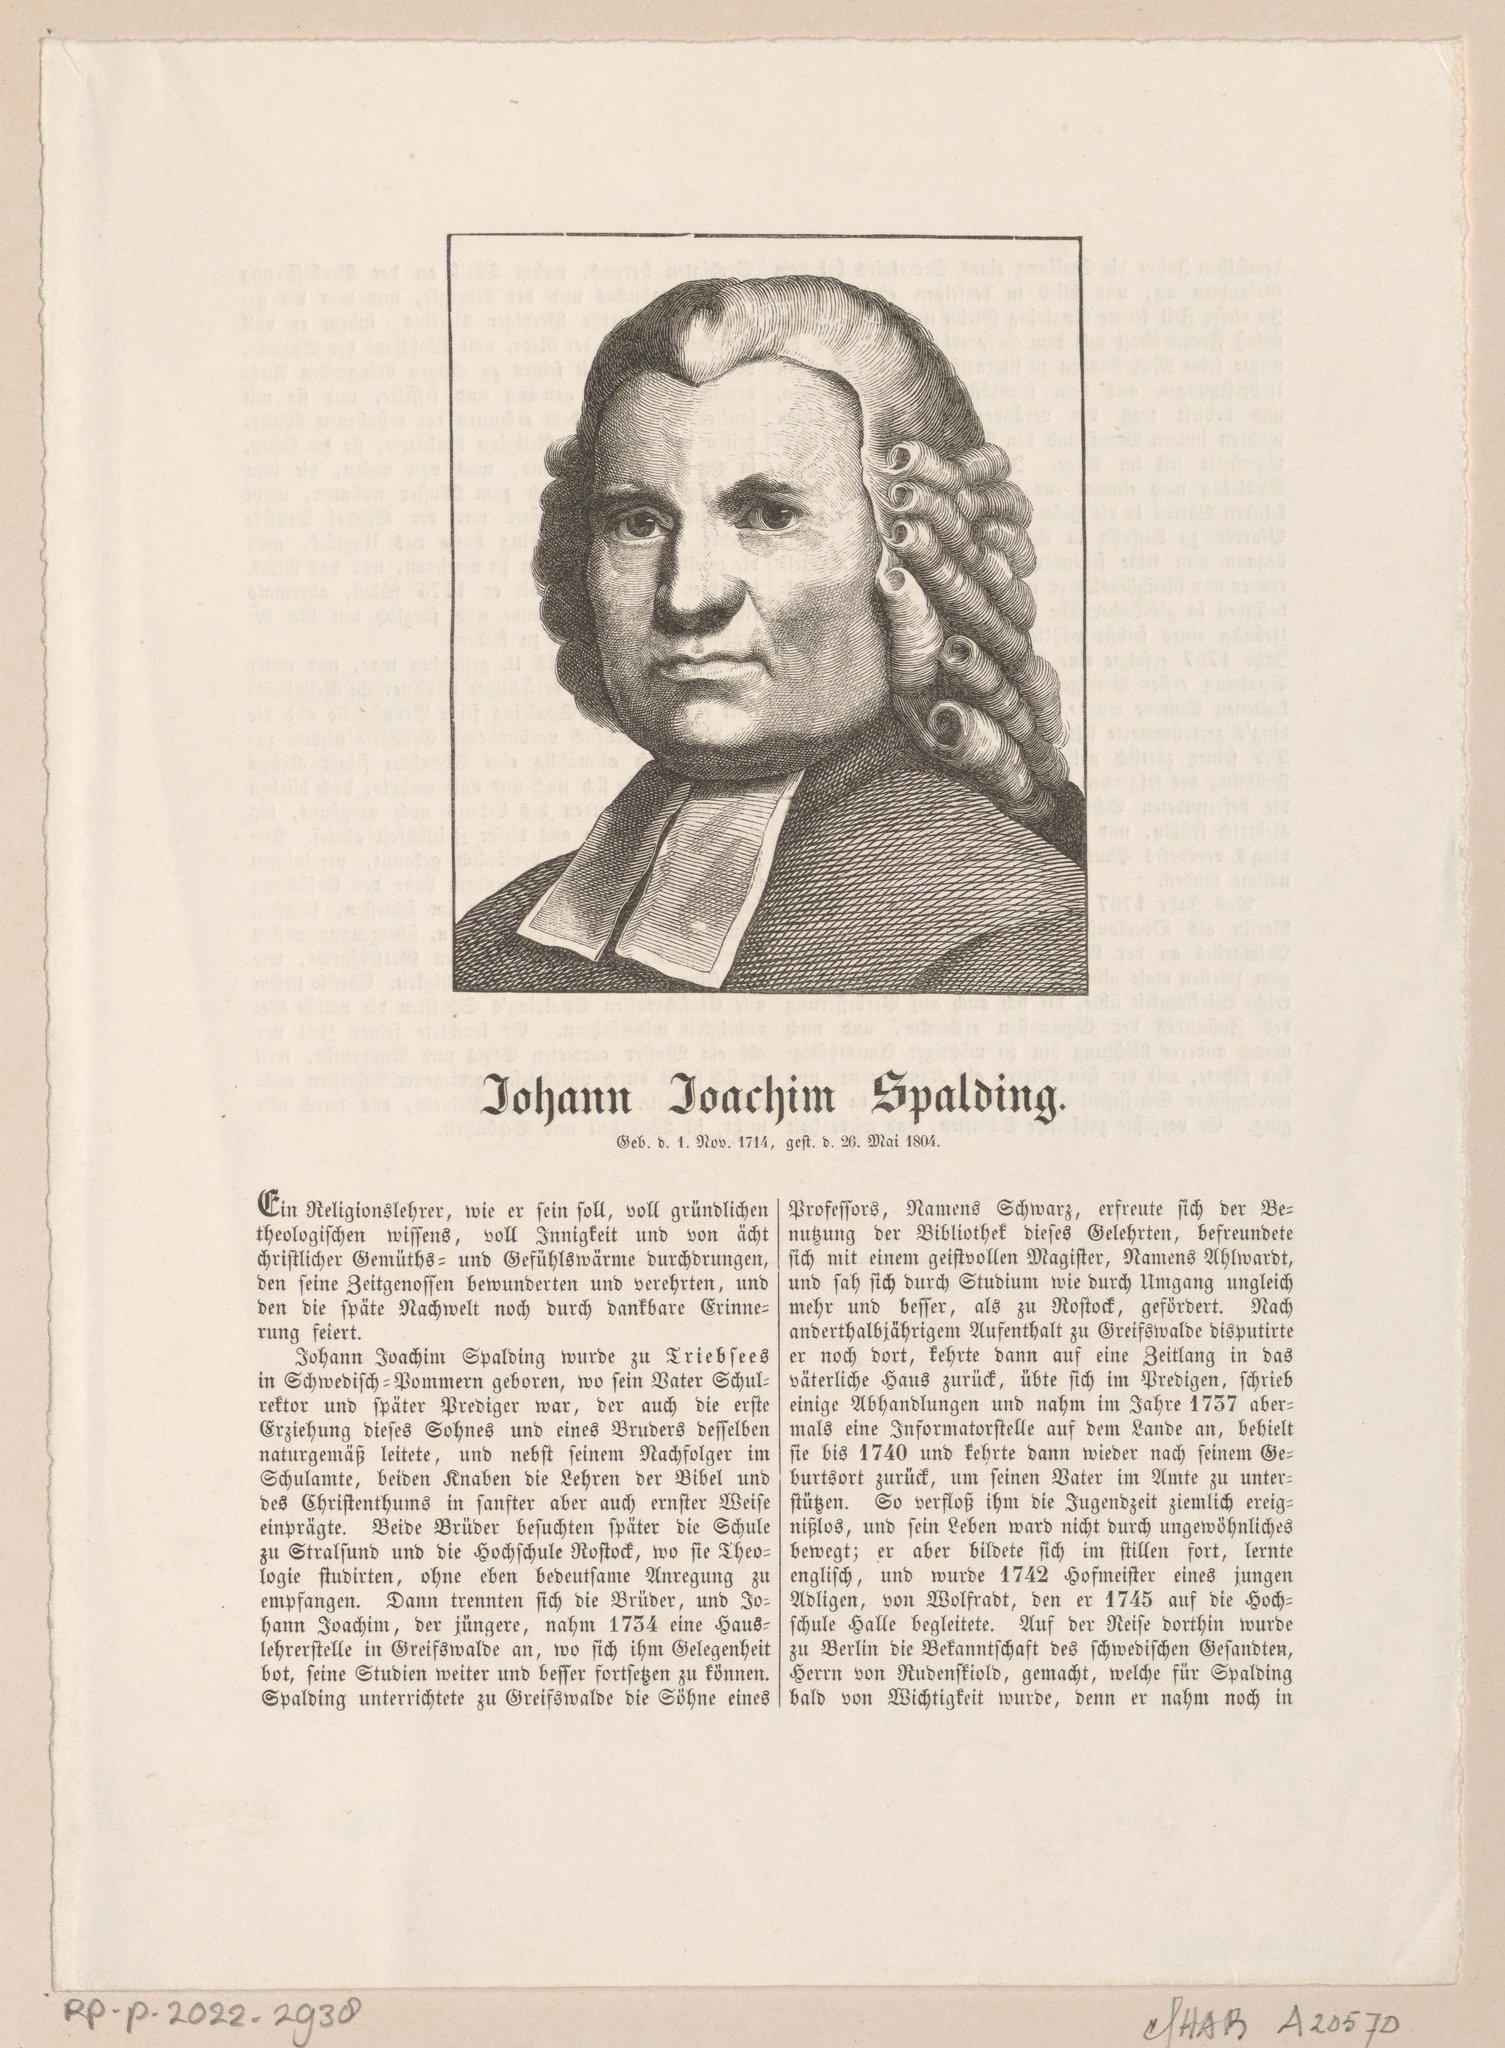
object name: page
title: Portret van Johann Joachim Spalding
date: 1854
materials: paper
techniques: letterpress printing, engraving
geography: germany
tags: johann joachim spalding, theologian, historical persons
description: Bladzijde uit: Bechstein, Ludwig. Zweihundert deutsche Männer in Bildnissen und Lebensbeschreibungen. Leipzig: Georg Wigand, 1854. Prent met andere tekst gebruikt in: Gaedertz, Karl Theodor. Dreihundert Bildnisse und Lebensabrisse berühmter deutscher Männer. Leipzig: Georg Wigand, 1890. Bij de uitgave uit 1890 staat op de titelpagina vermeld dat de prenten zijn gemaakt door Hugo Bürkner.